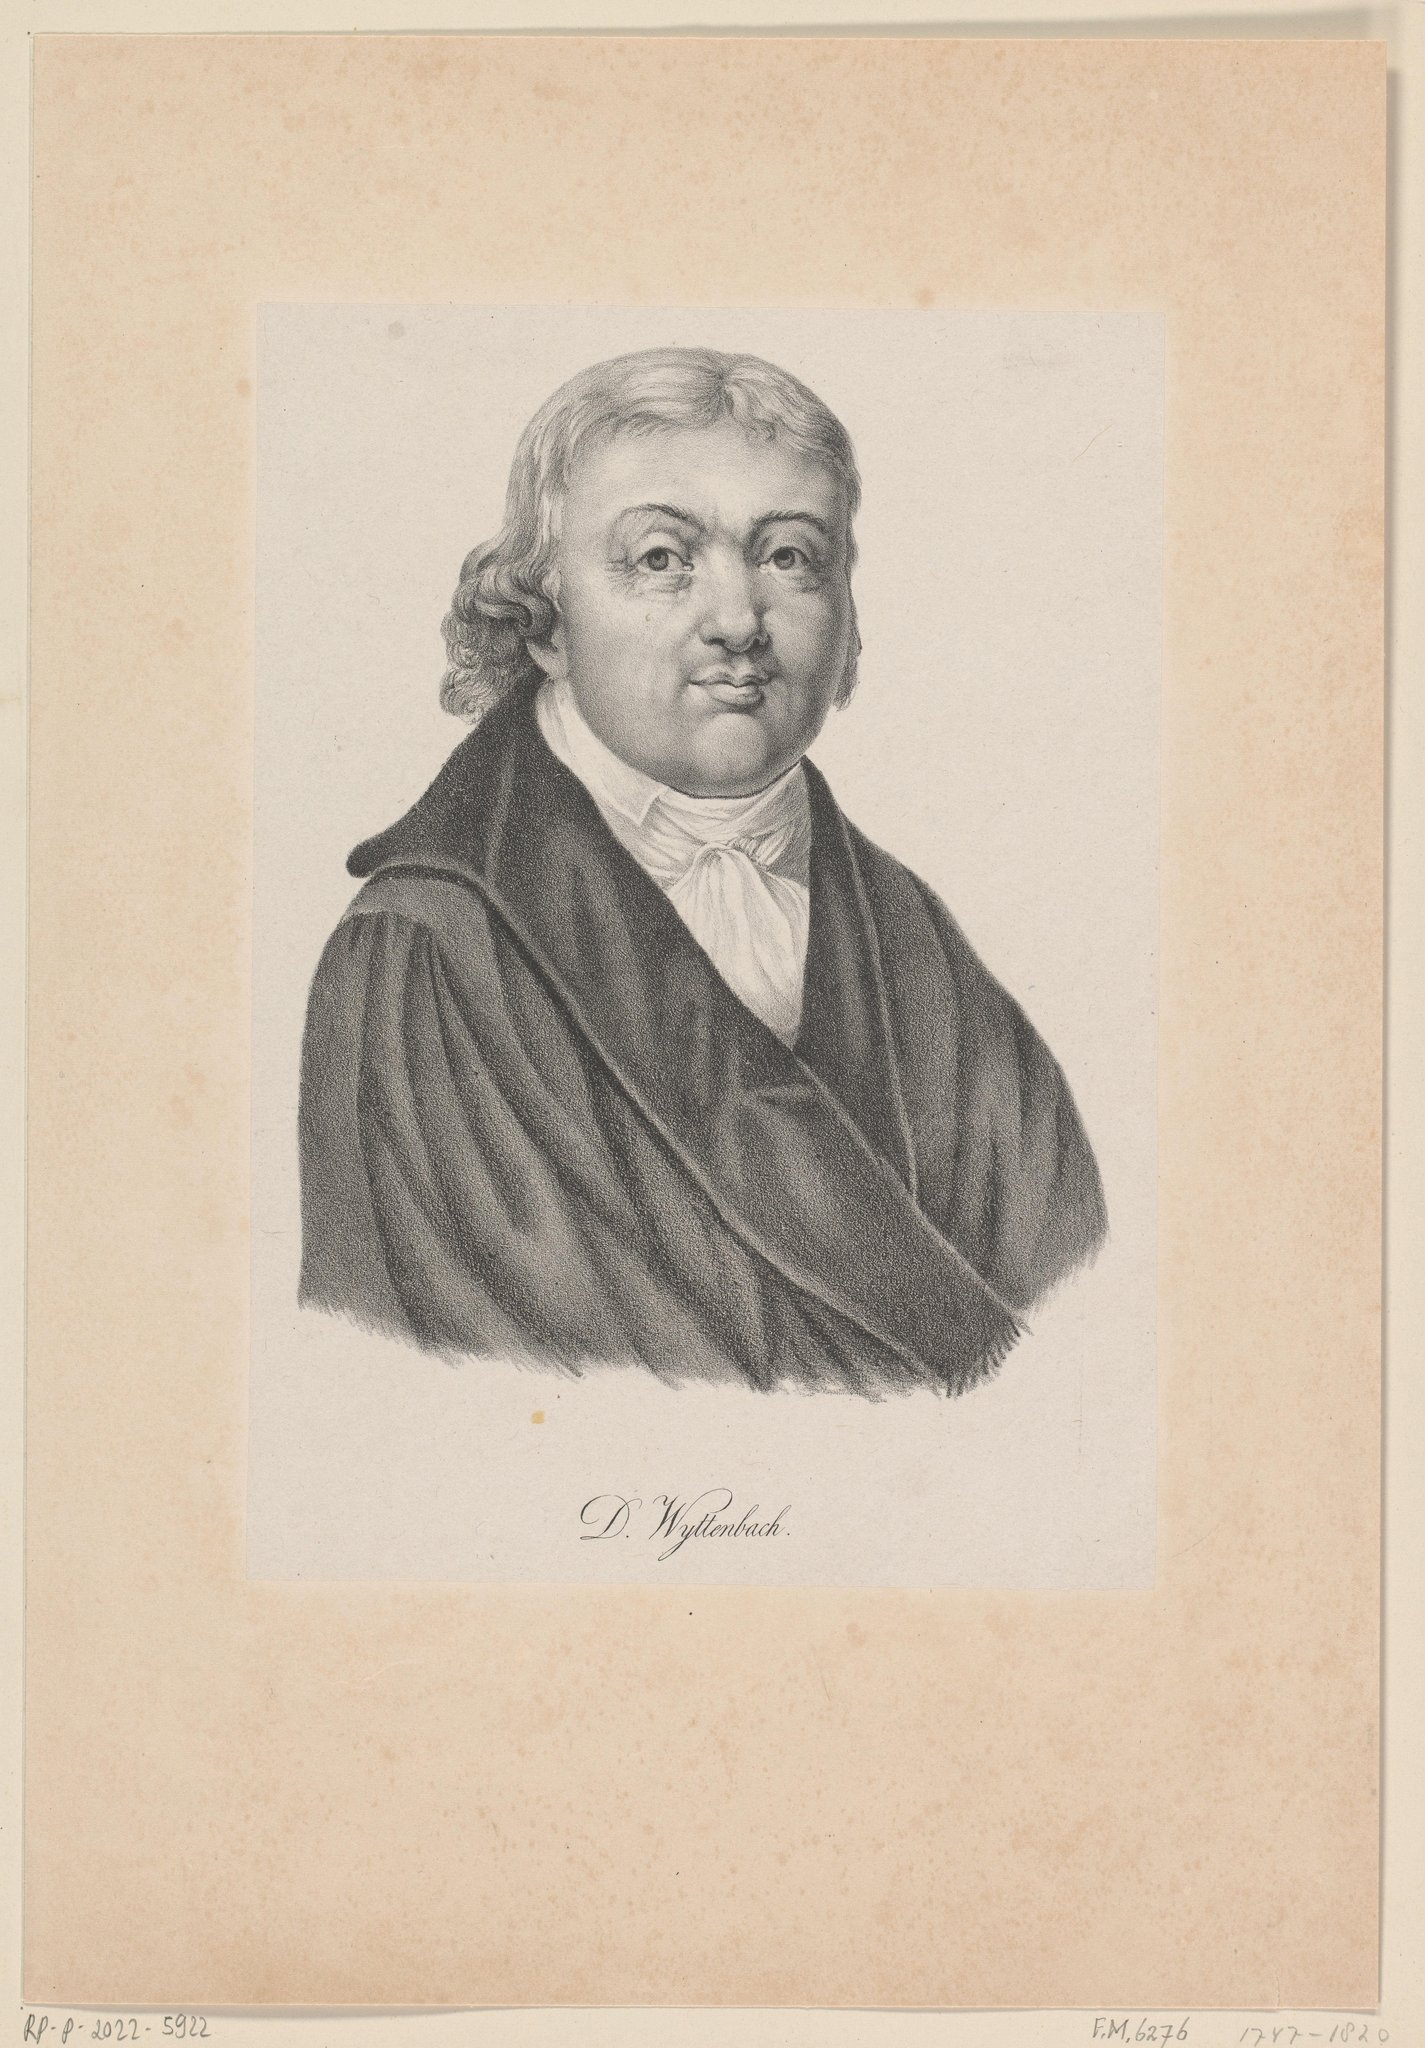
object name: print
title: Portret van Daniël Wyttenbach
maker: Anonymous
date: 1800-1850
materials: paper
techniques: lithograph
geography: netherlands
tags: historical persons, professor